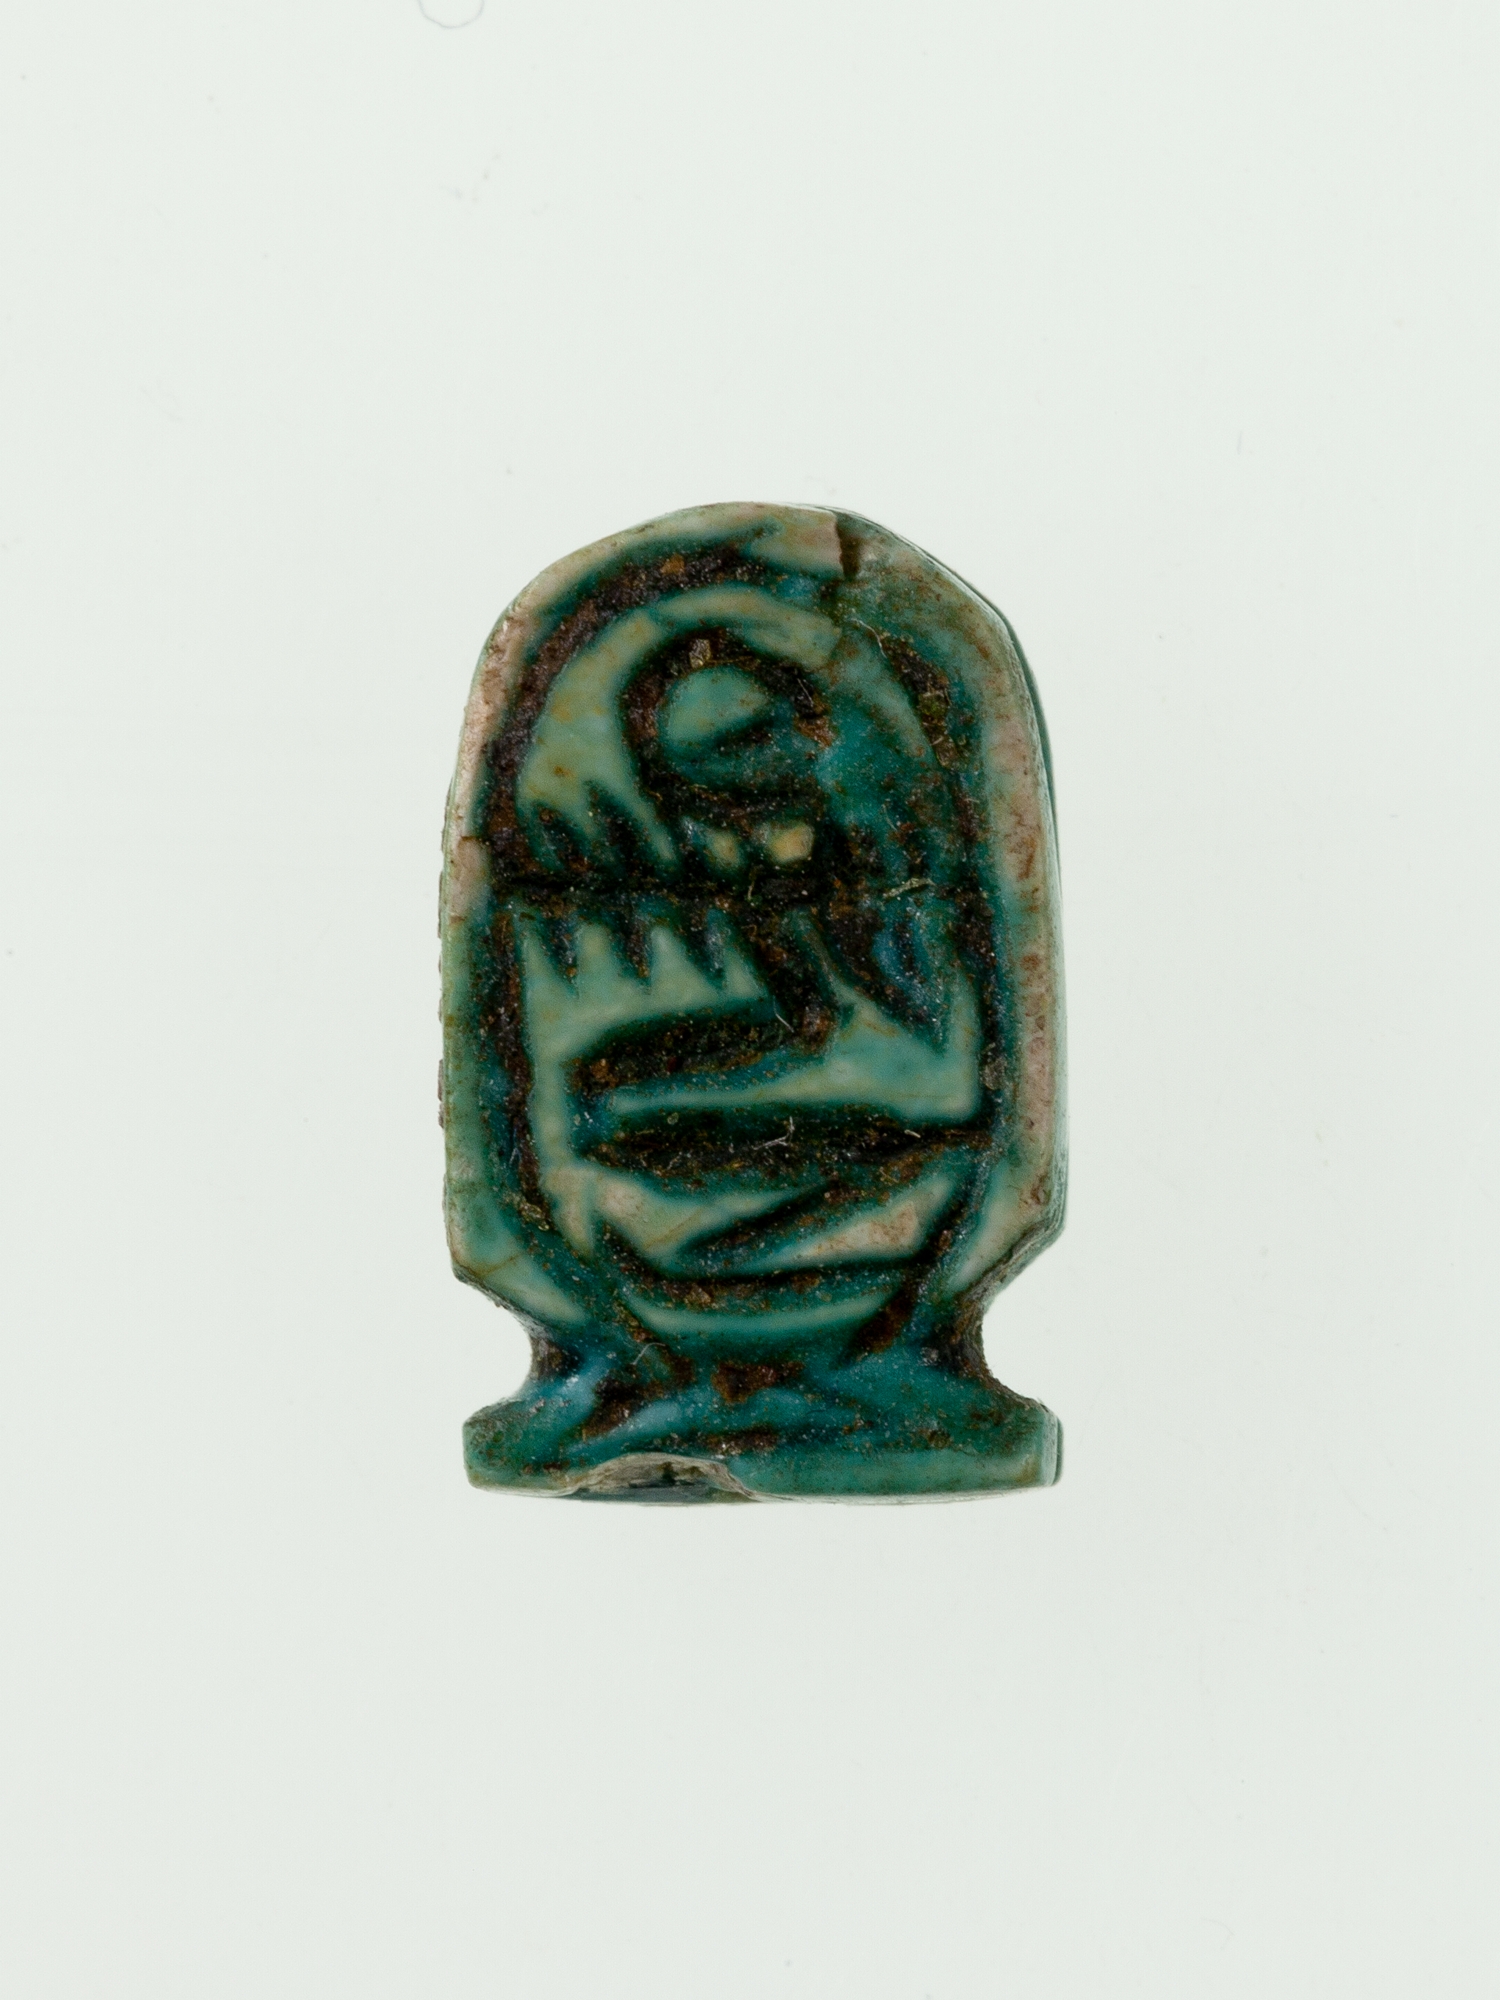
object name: seal amulet, cartouche, hieroglyph, amenemhat iii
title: Cartouche amulet of Amenemhat III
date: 1859-1813 BCE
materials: stone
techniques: glazing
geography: egypt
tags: scarabs